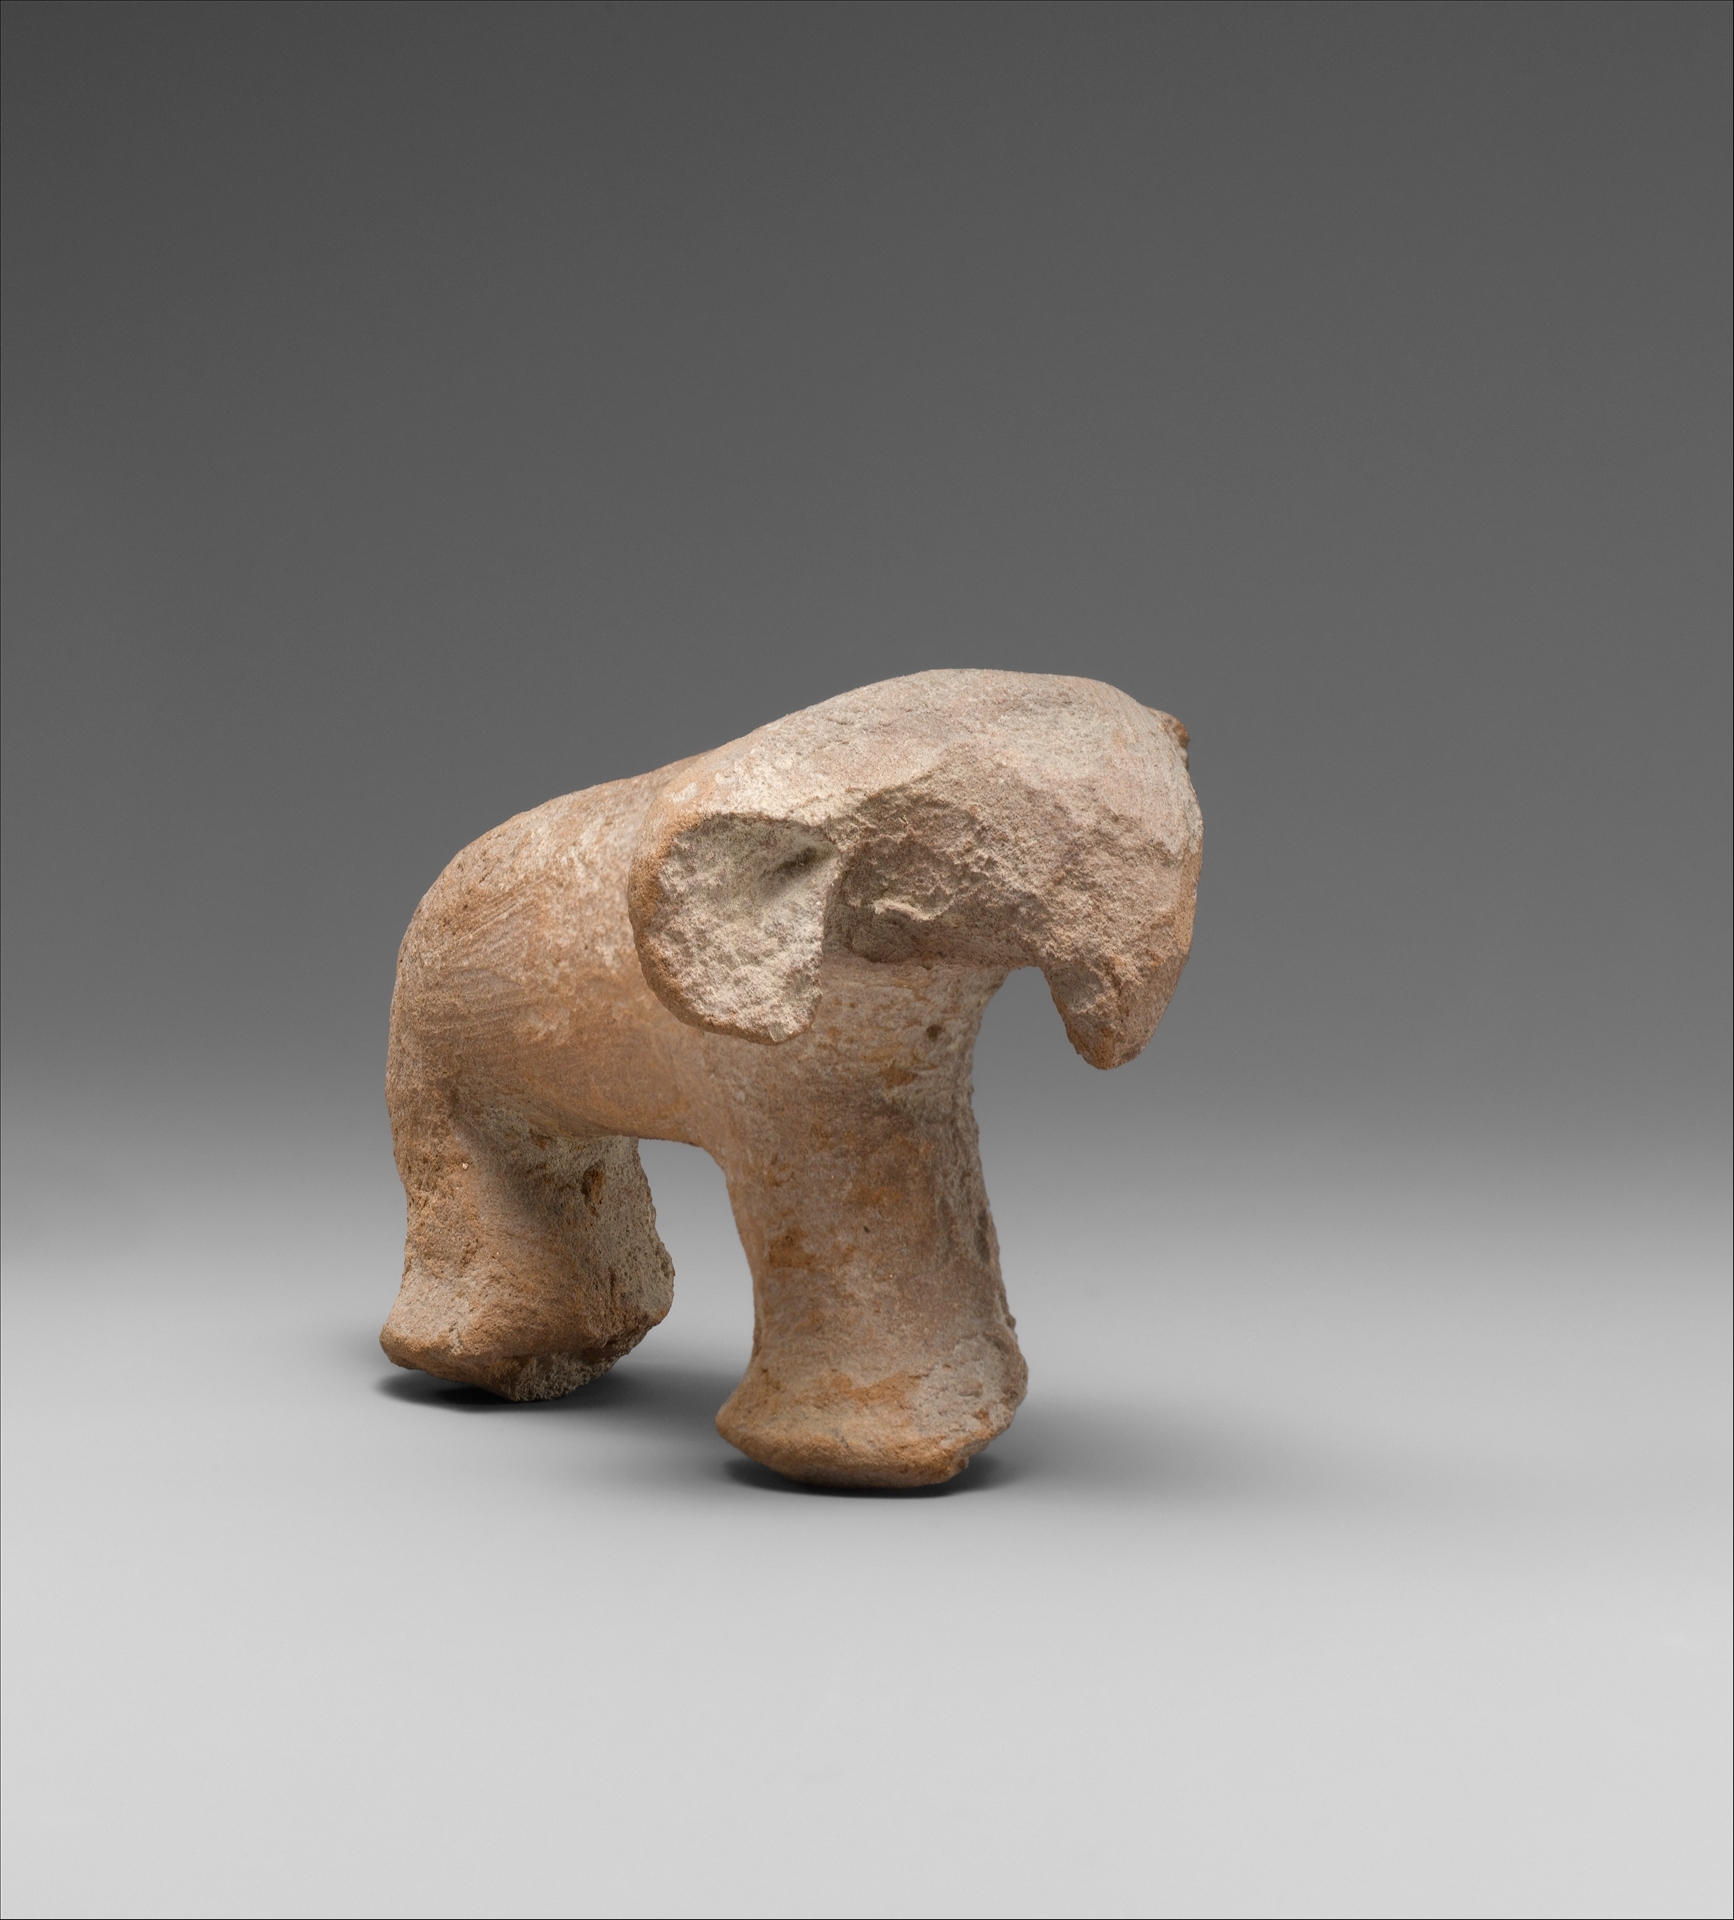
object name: figurine, elephant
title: Elephant Figurine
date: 3700-3450 BCE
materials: pottery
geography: egypt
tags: elephants